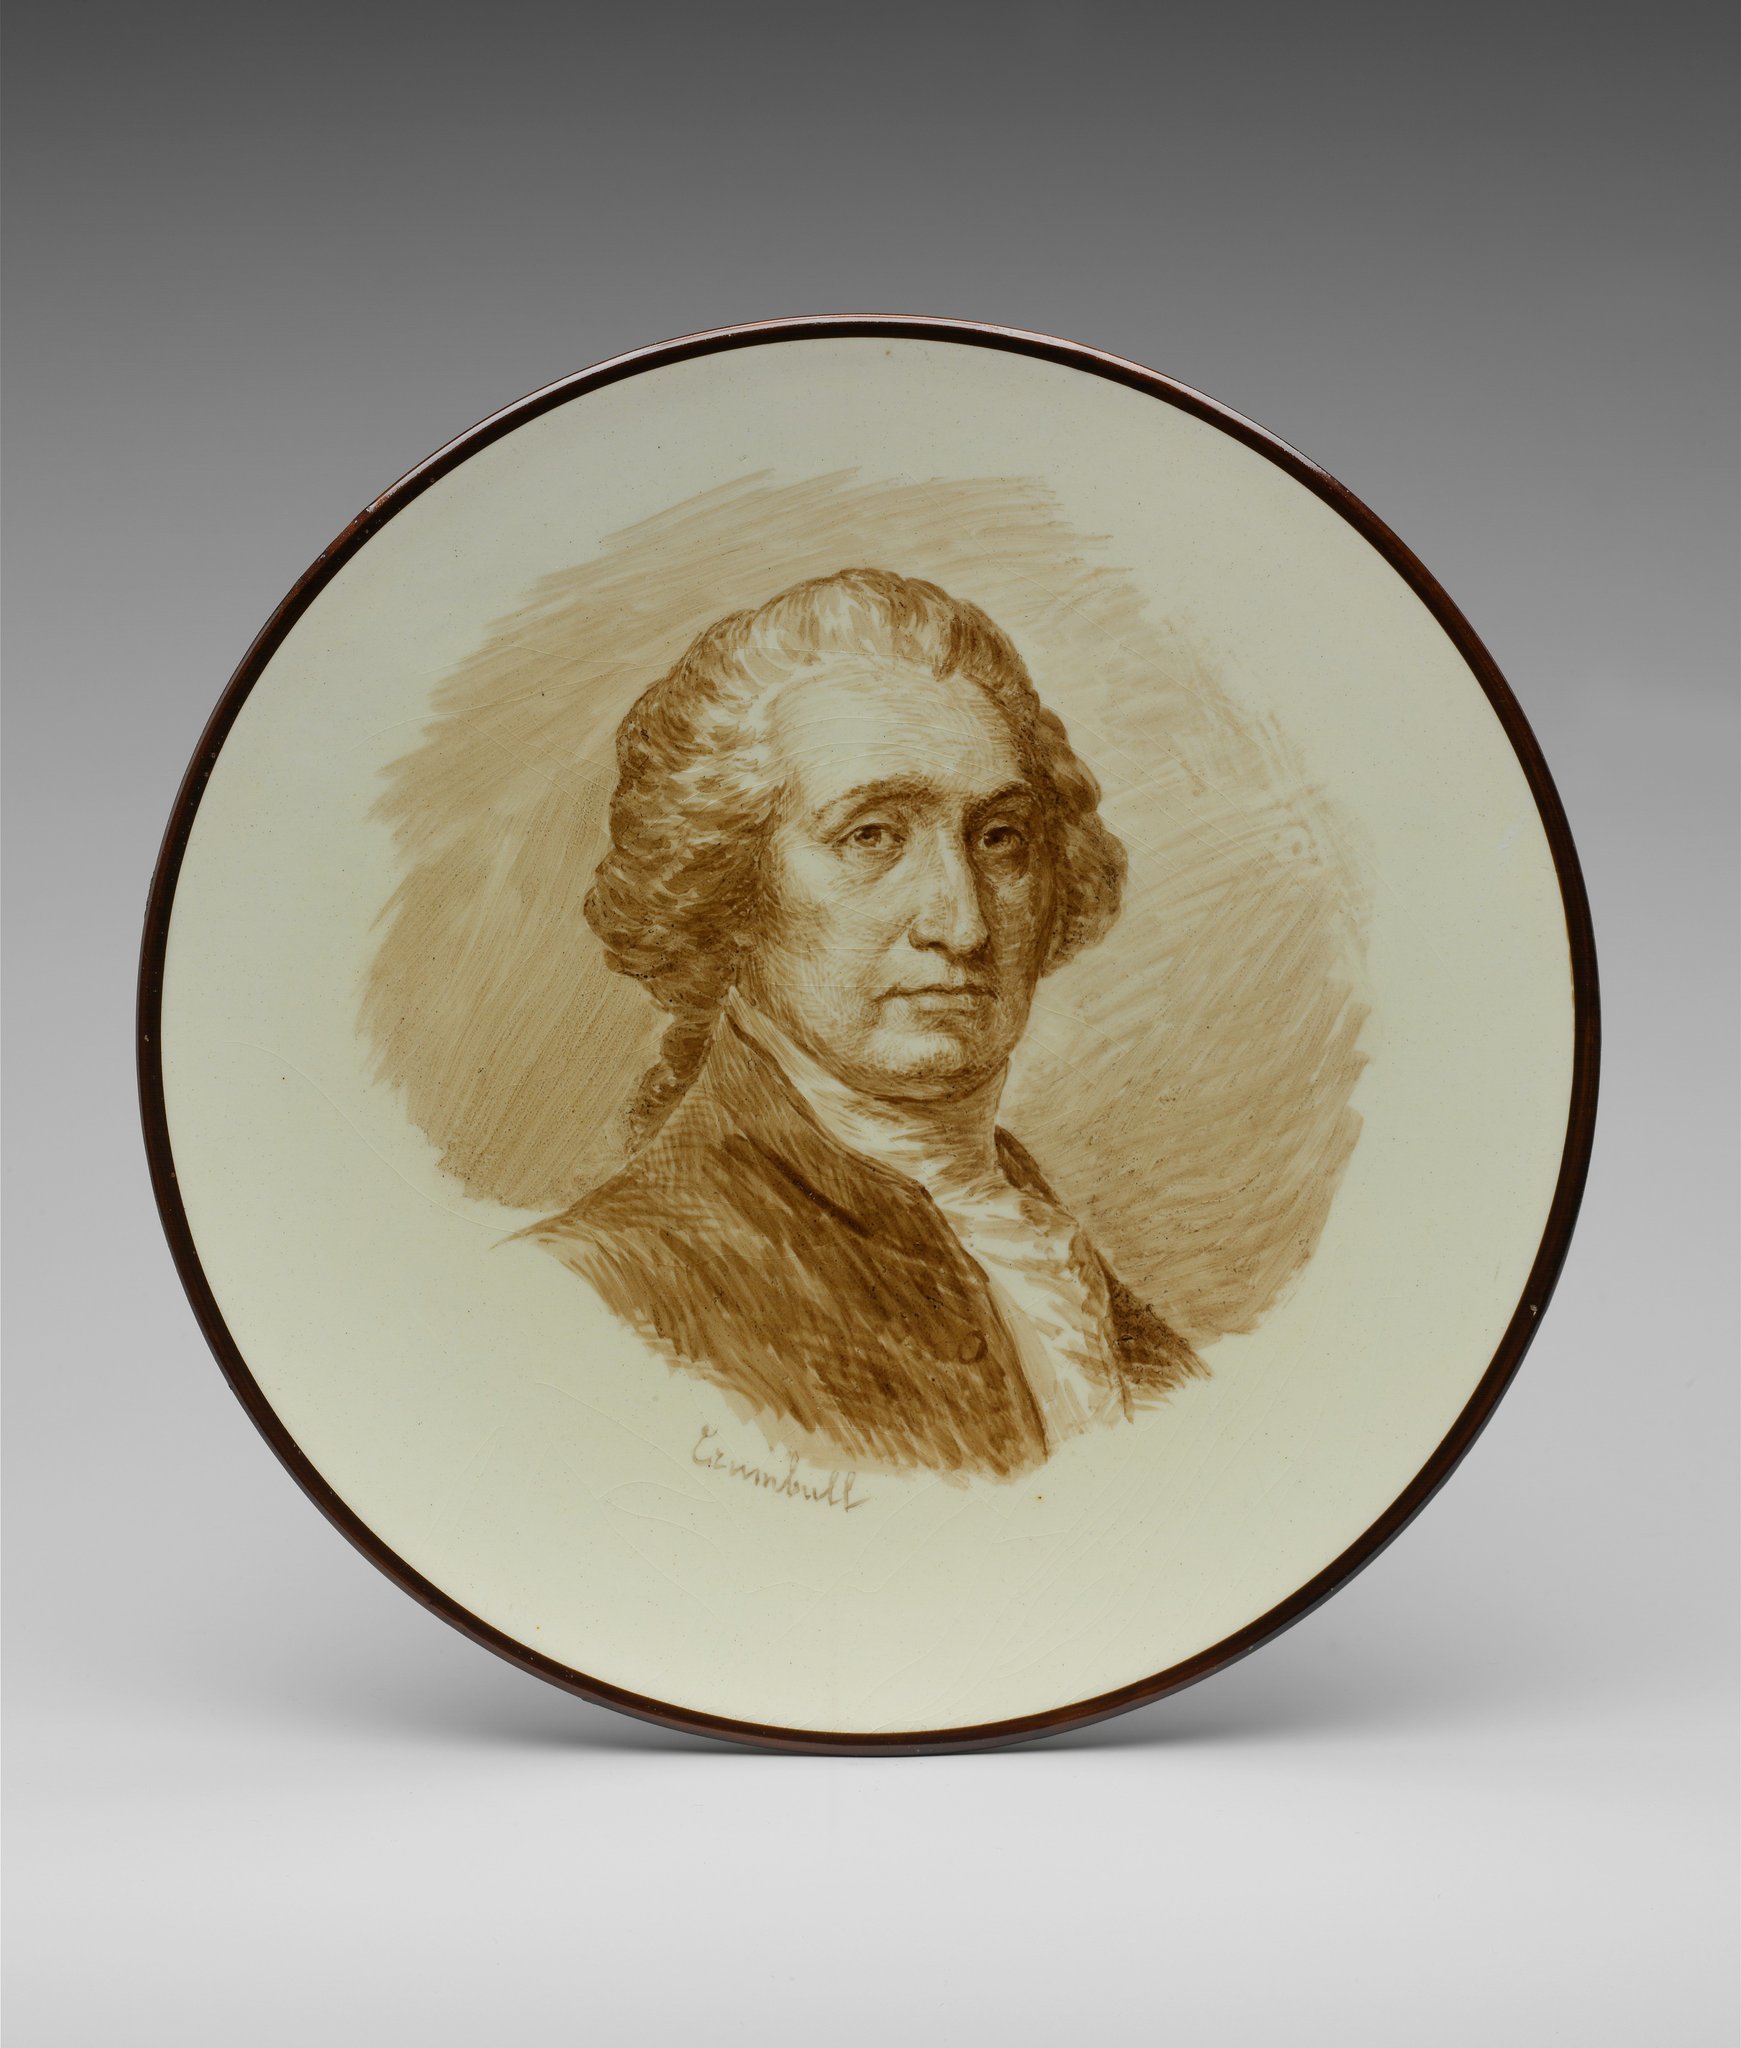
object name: plaque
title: George Washington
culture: french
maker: emile dupont-zipcy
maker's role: maker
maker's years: 1822-1885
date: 1840-1883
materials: faience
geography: france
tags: george washington,men,portraits